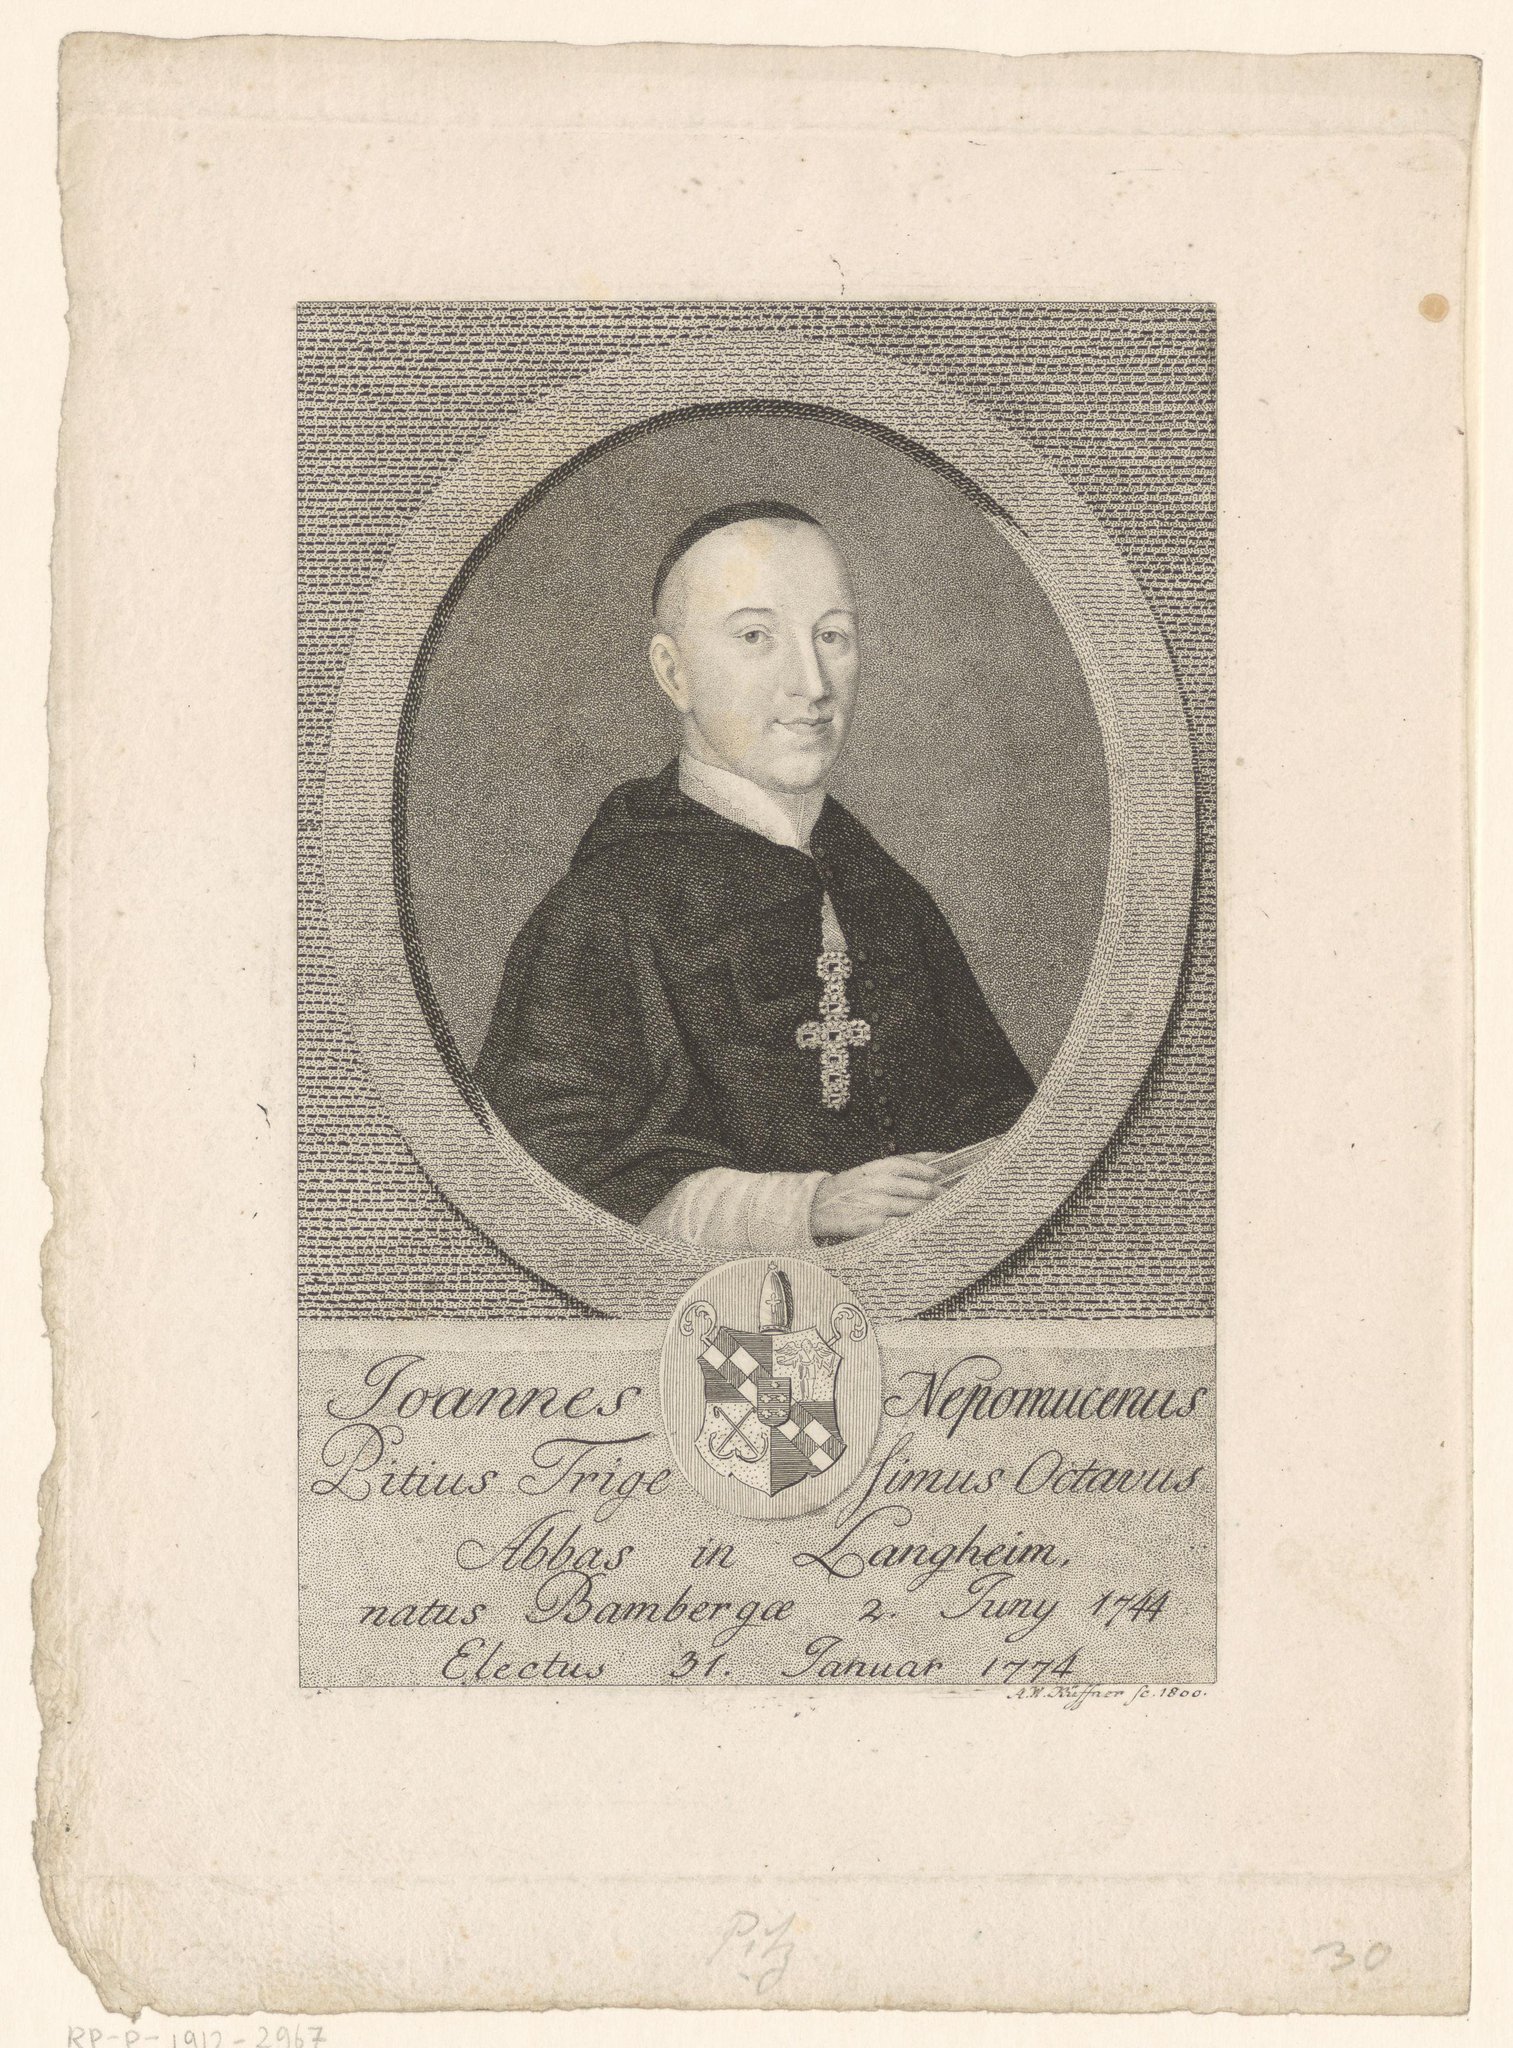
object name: print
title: Portret van Johann Nepomucenus Pitius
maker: abraham wolfgang küfner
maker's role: print maker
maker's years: 1760-1817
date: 1800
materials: paper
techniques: etching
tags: theologian, historical persons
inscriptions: collector's mark: Lugt 2228